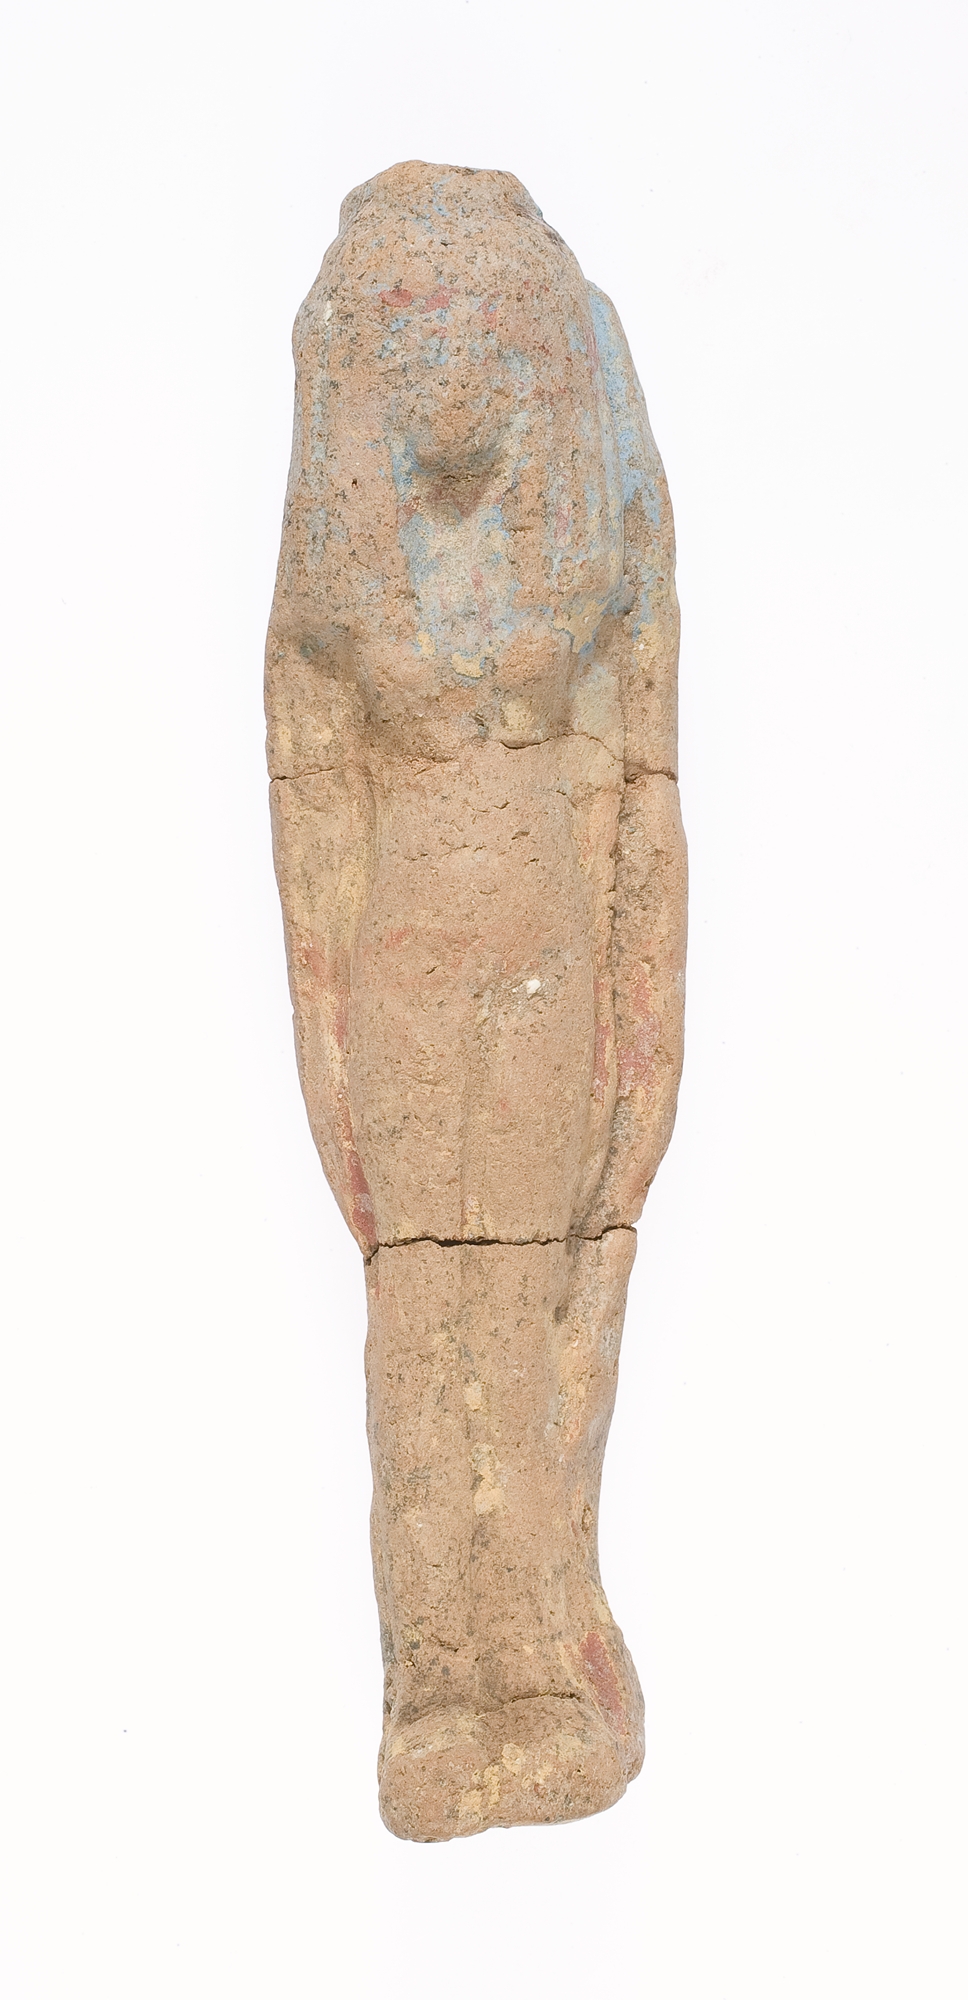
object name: statuette of a woman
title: Standing female figurine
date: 1390-1186 BCE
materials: pottery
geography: egypt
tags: women